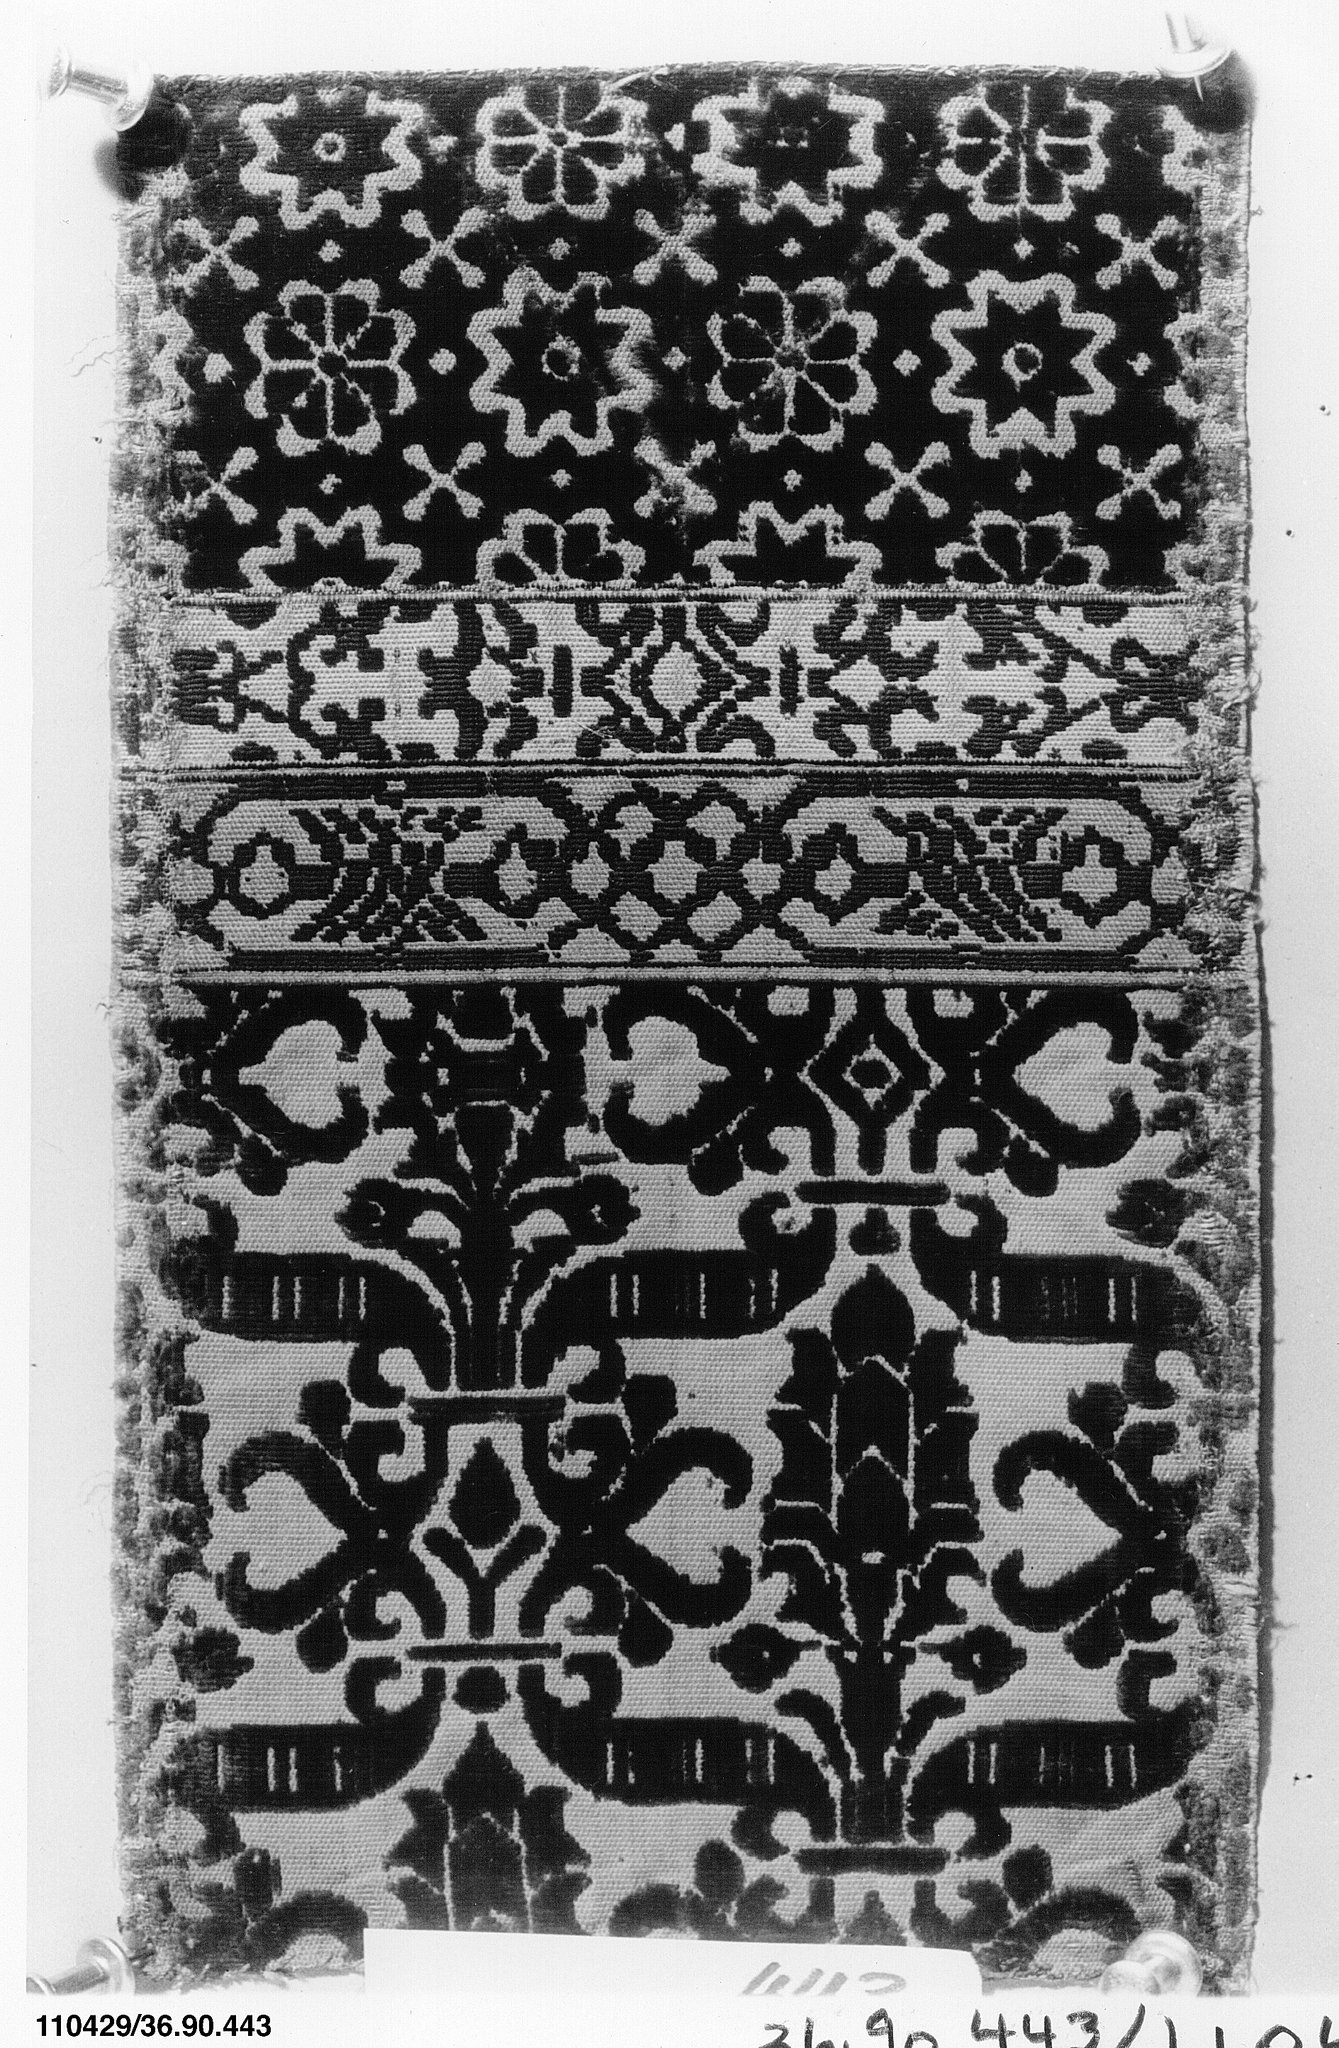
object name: piece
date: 1801-1900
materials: silk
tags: flowers